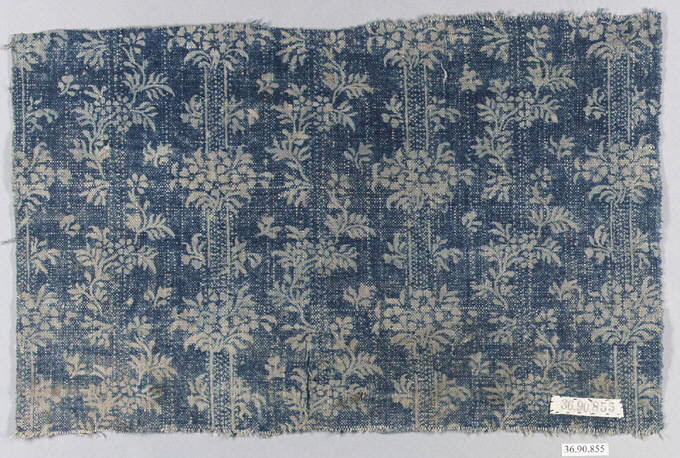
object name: piece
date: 1701-1800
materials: cotton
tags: flowers,leaves